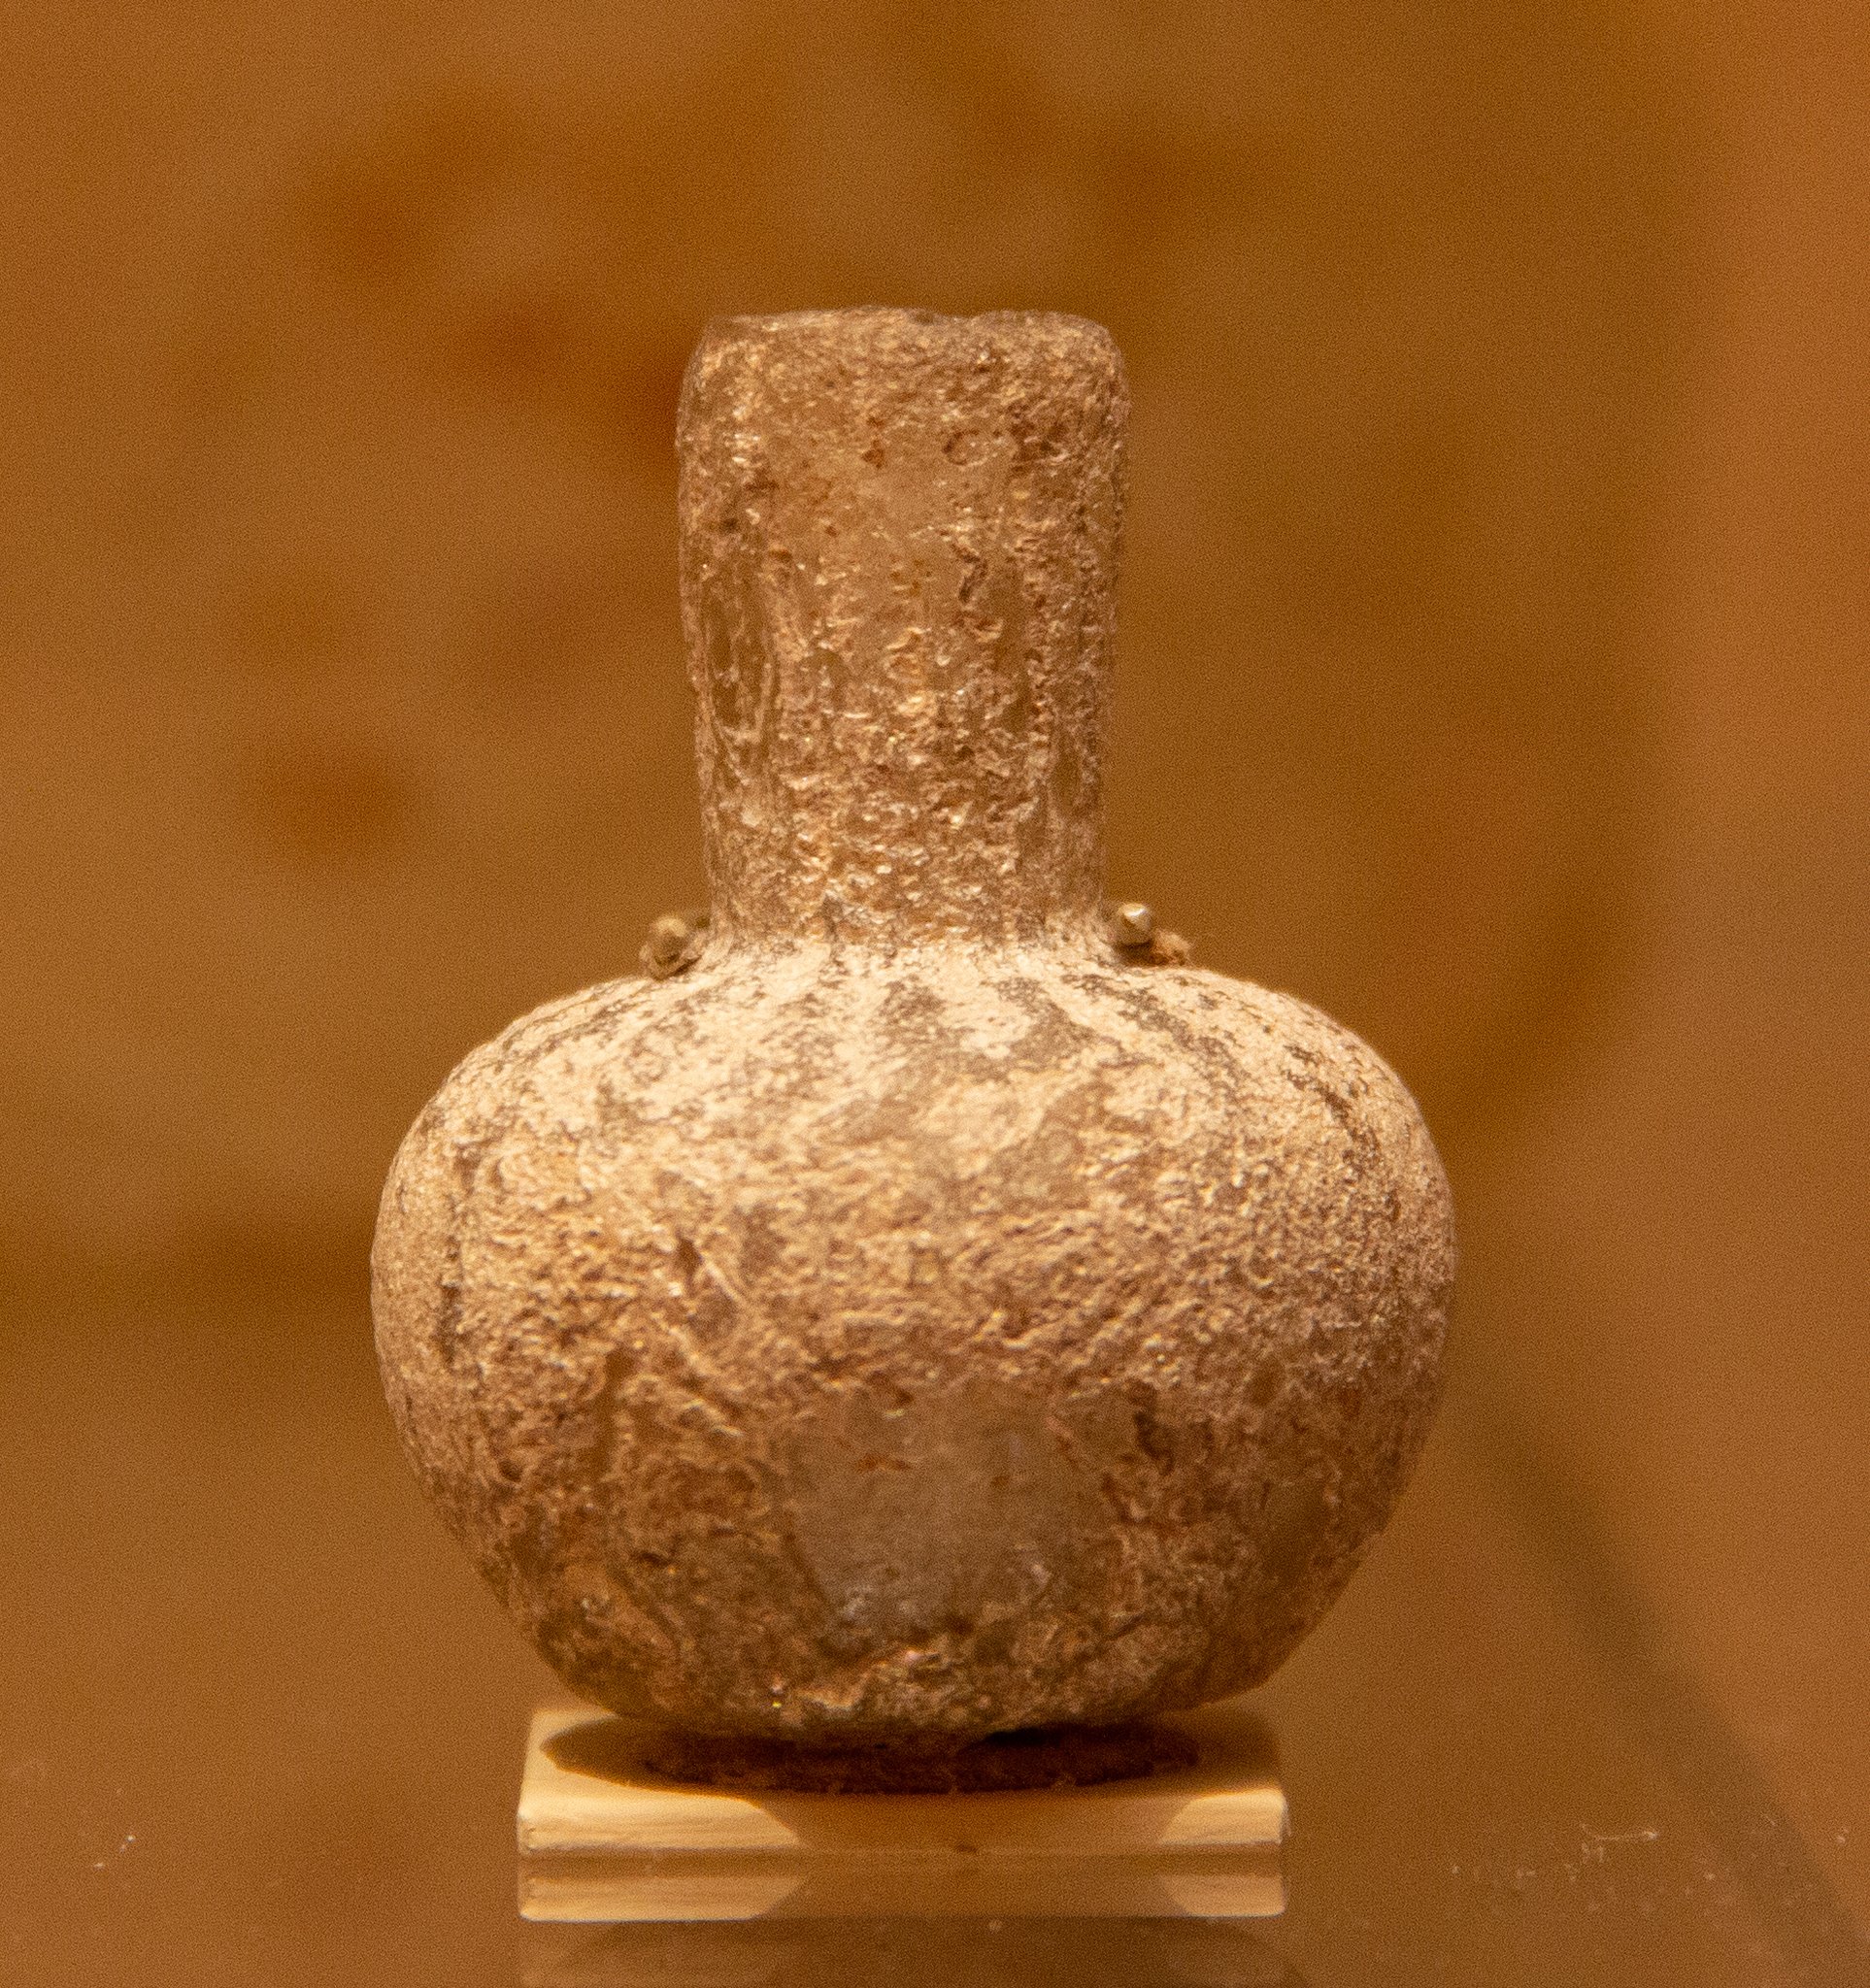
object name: bottle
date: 801-1000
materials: glass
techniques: glassblowing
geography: iran